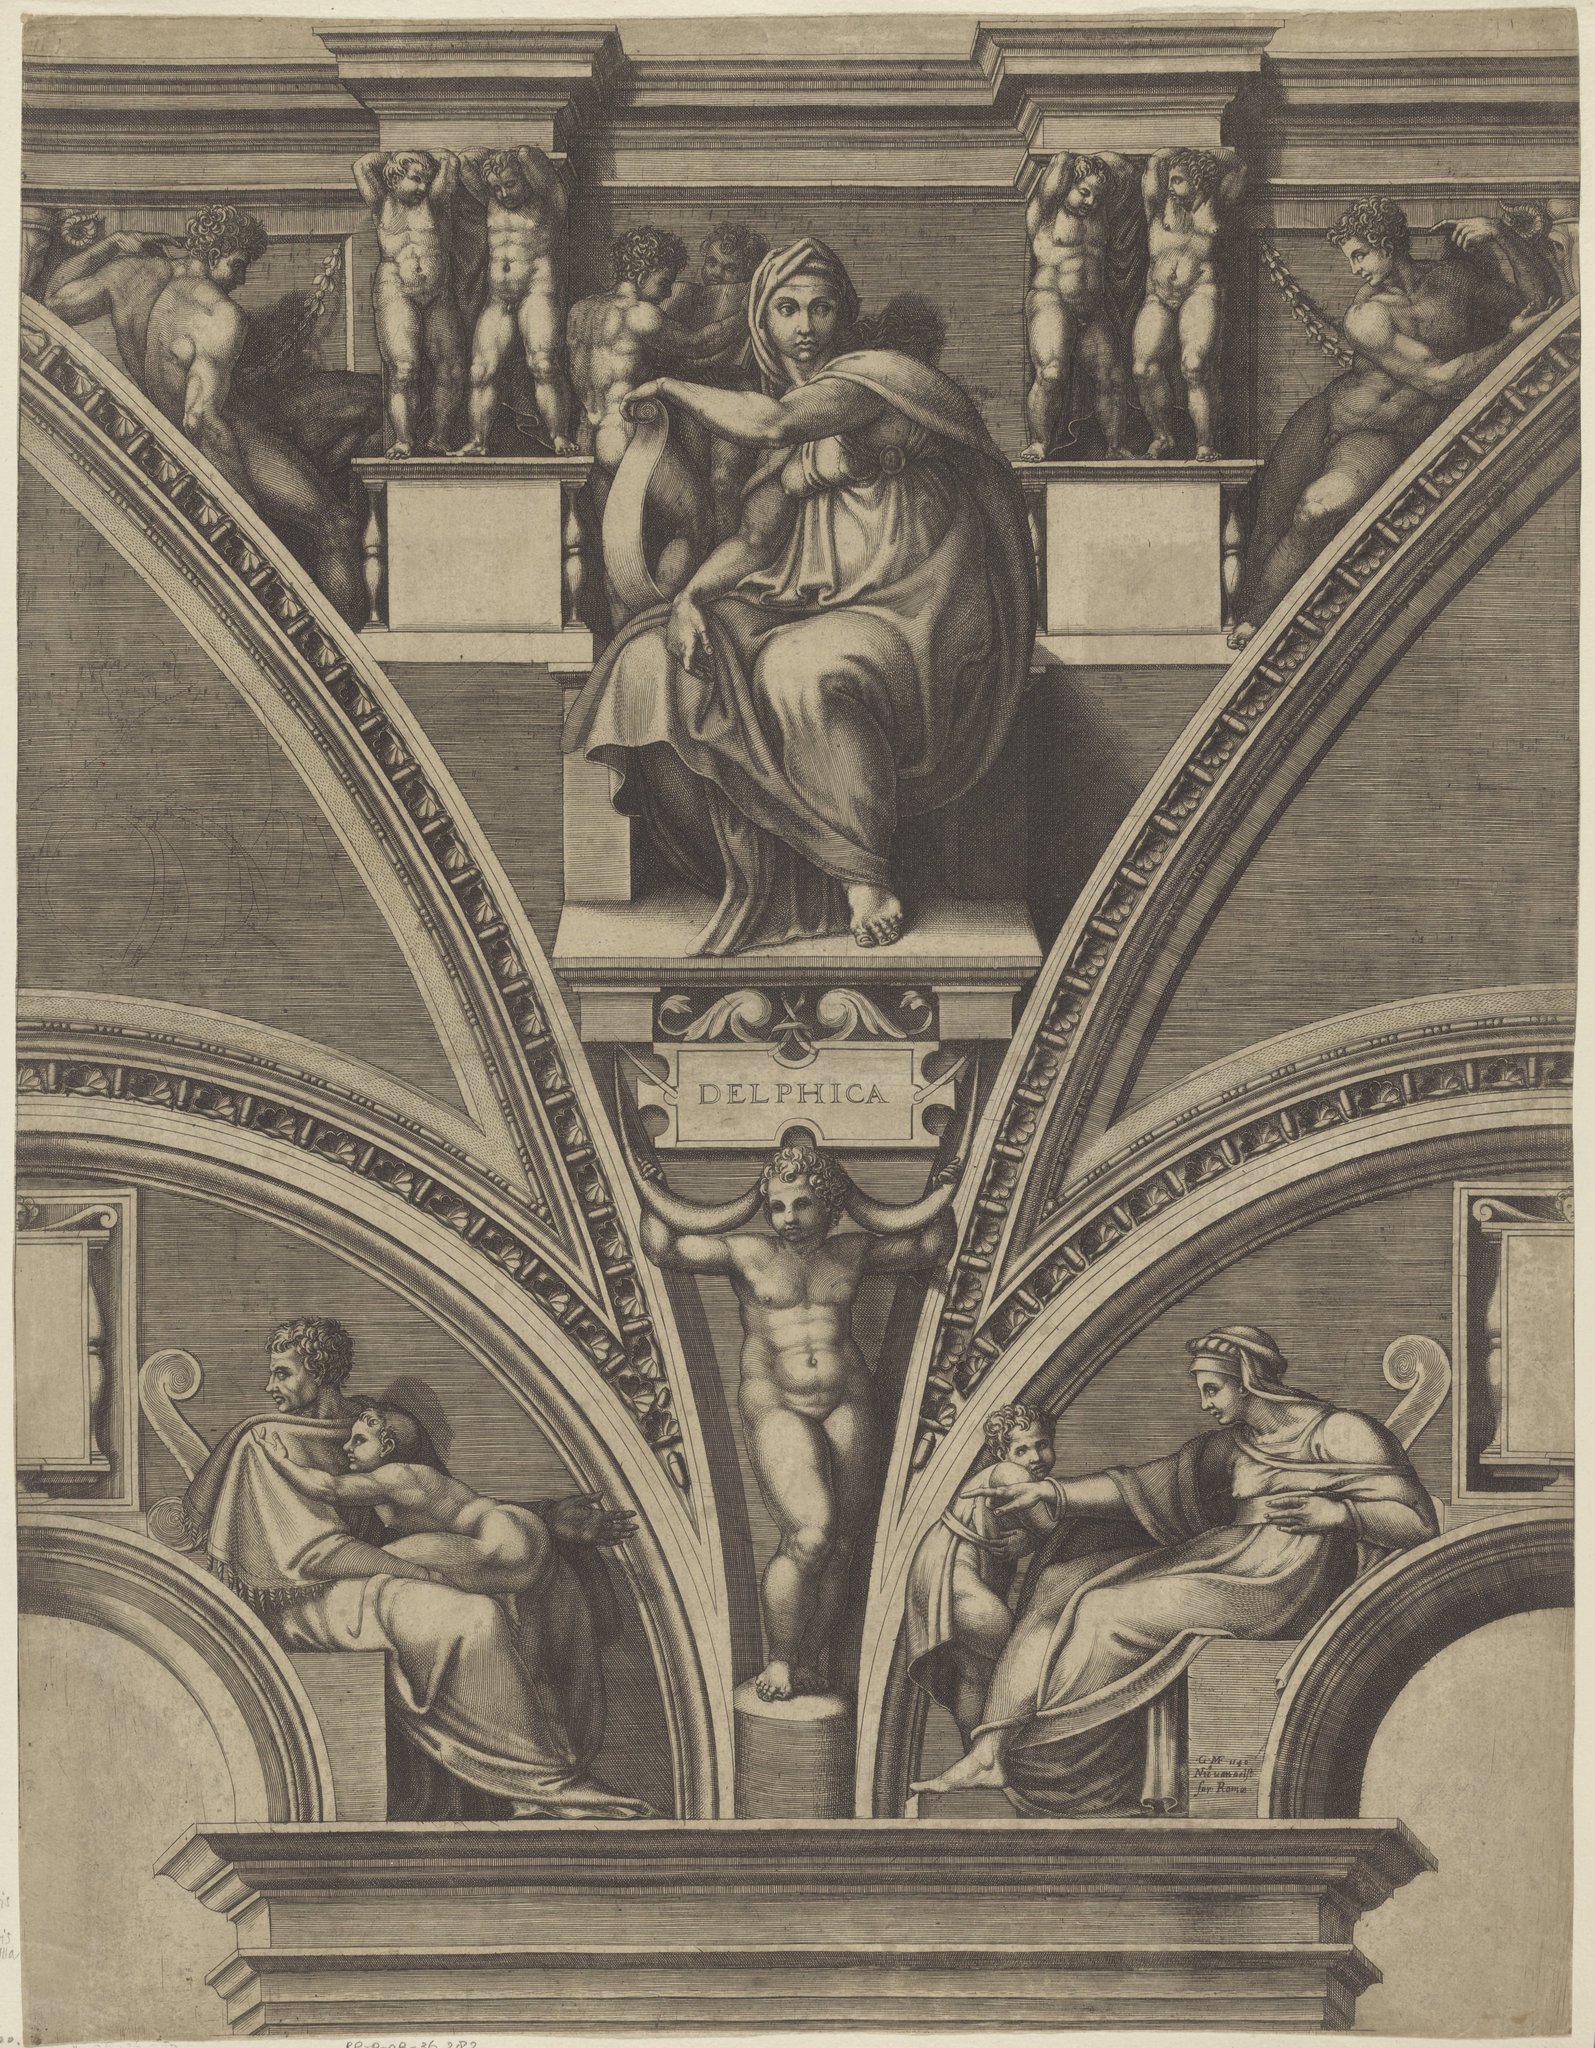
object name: print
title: Delfische Sibille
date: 1540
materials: paper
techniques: engraving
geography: italy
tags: sibyls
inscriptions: collector's mark: Lugt 240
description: Prent uit een reeks van 6 prenten naar de schilderingen in de lunetten boven de ramen in de Sixtijnse Kapel door Michelangelo.